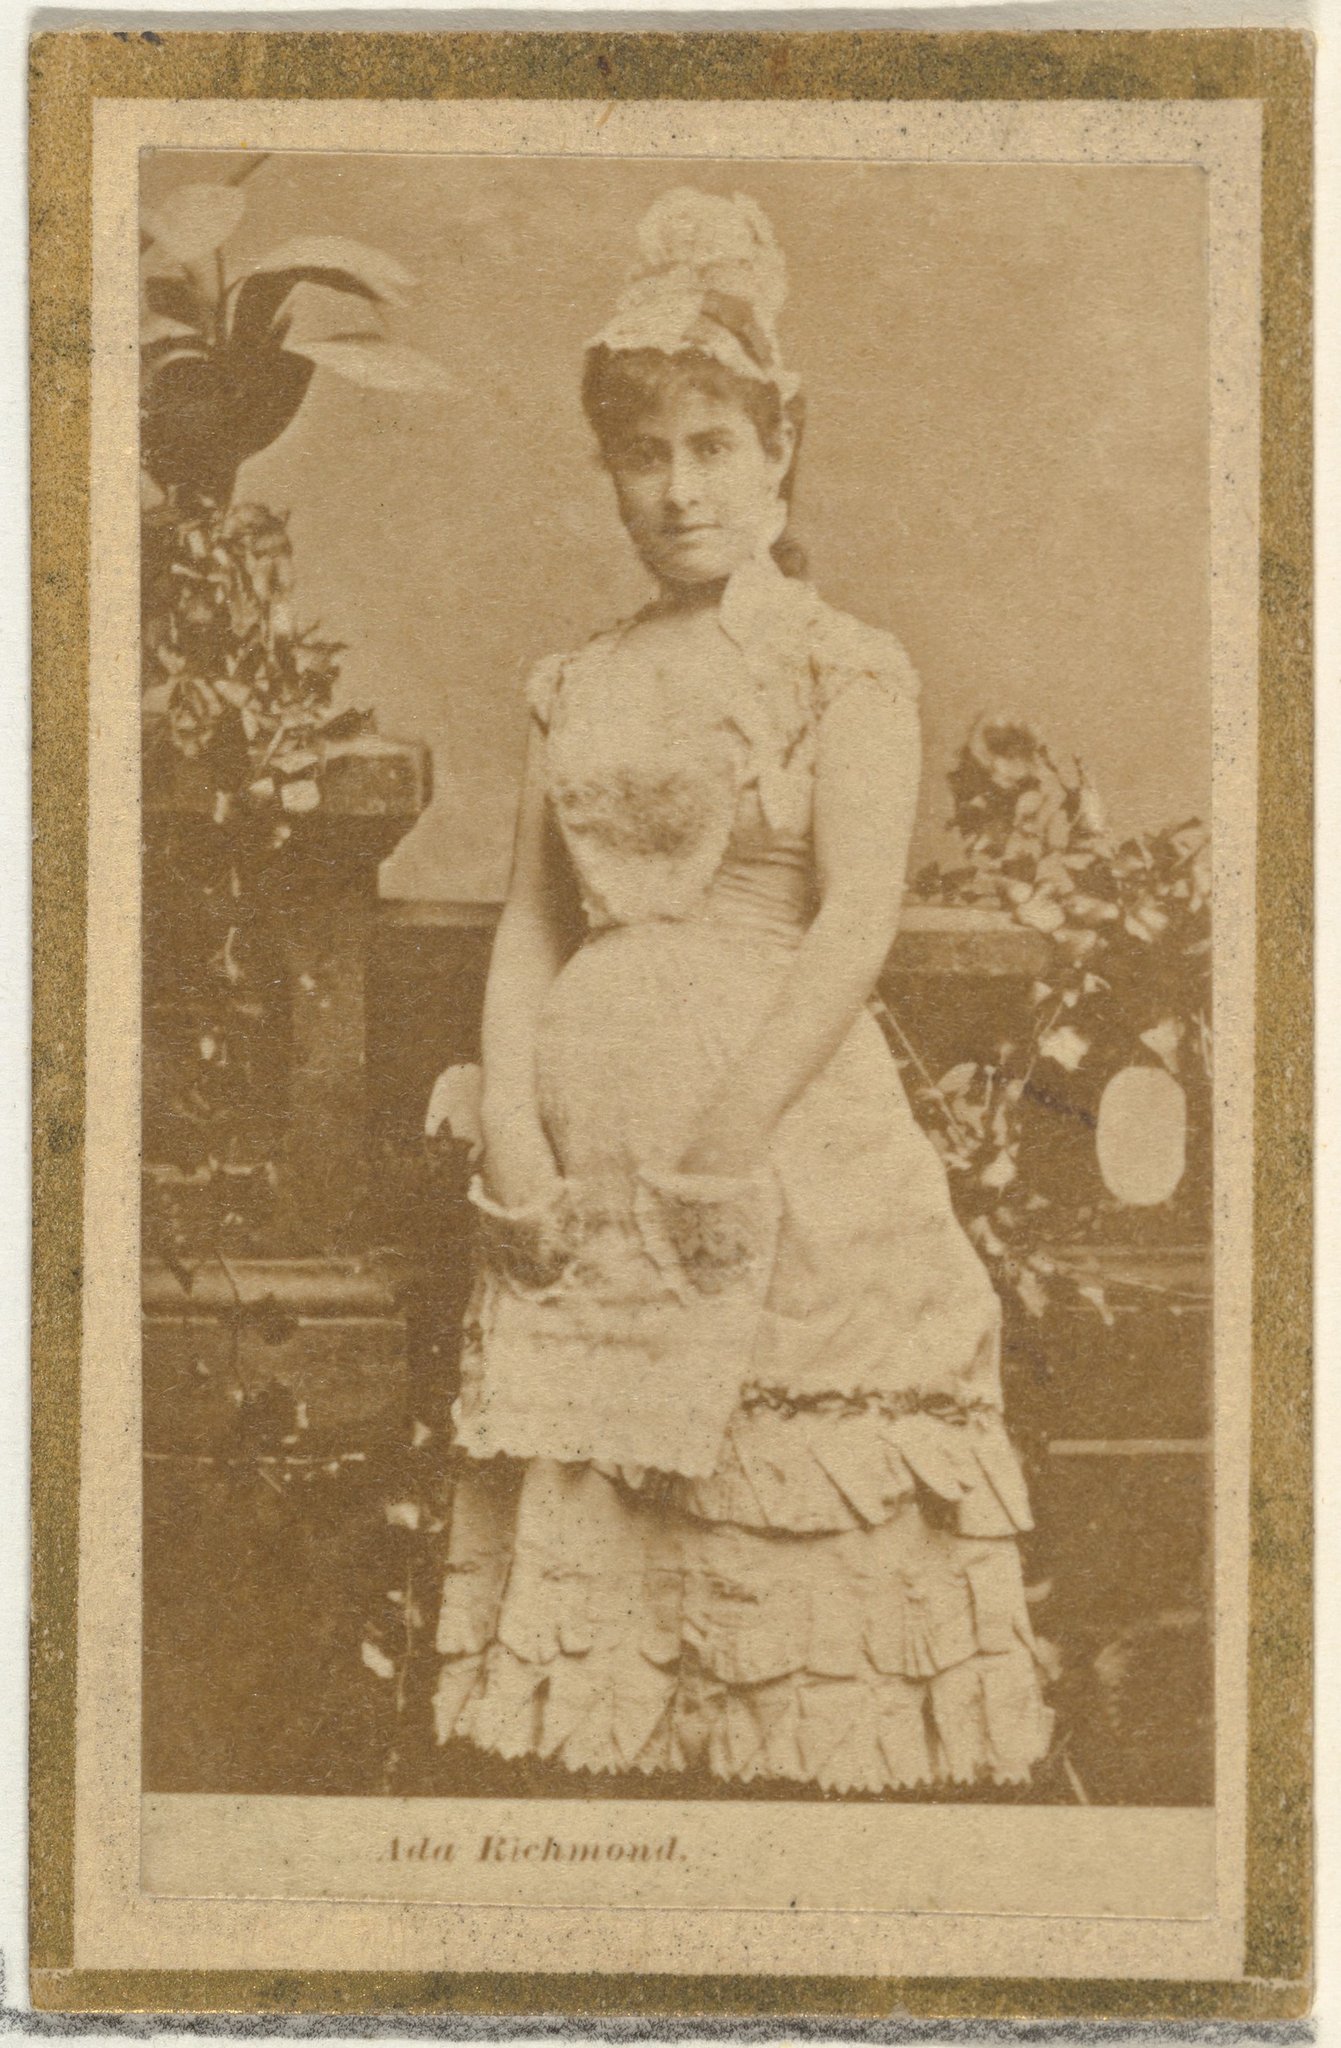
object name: photograph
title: Ada Richmond, from the Actresses and Celebrities series (N60, Type 2) promoting Little Beauties Cigarettes for Allen & Ginter brand tobacco products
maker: allen & ginter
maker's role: publisher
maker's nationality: american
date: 1887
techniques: albumen silver print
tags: portraits,women,actresses